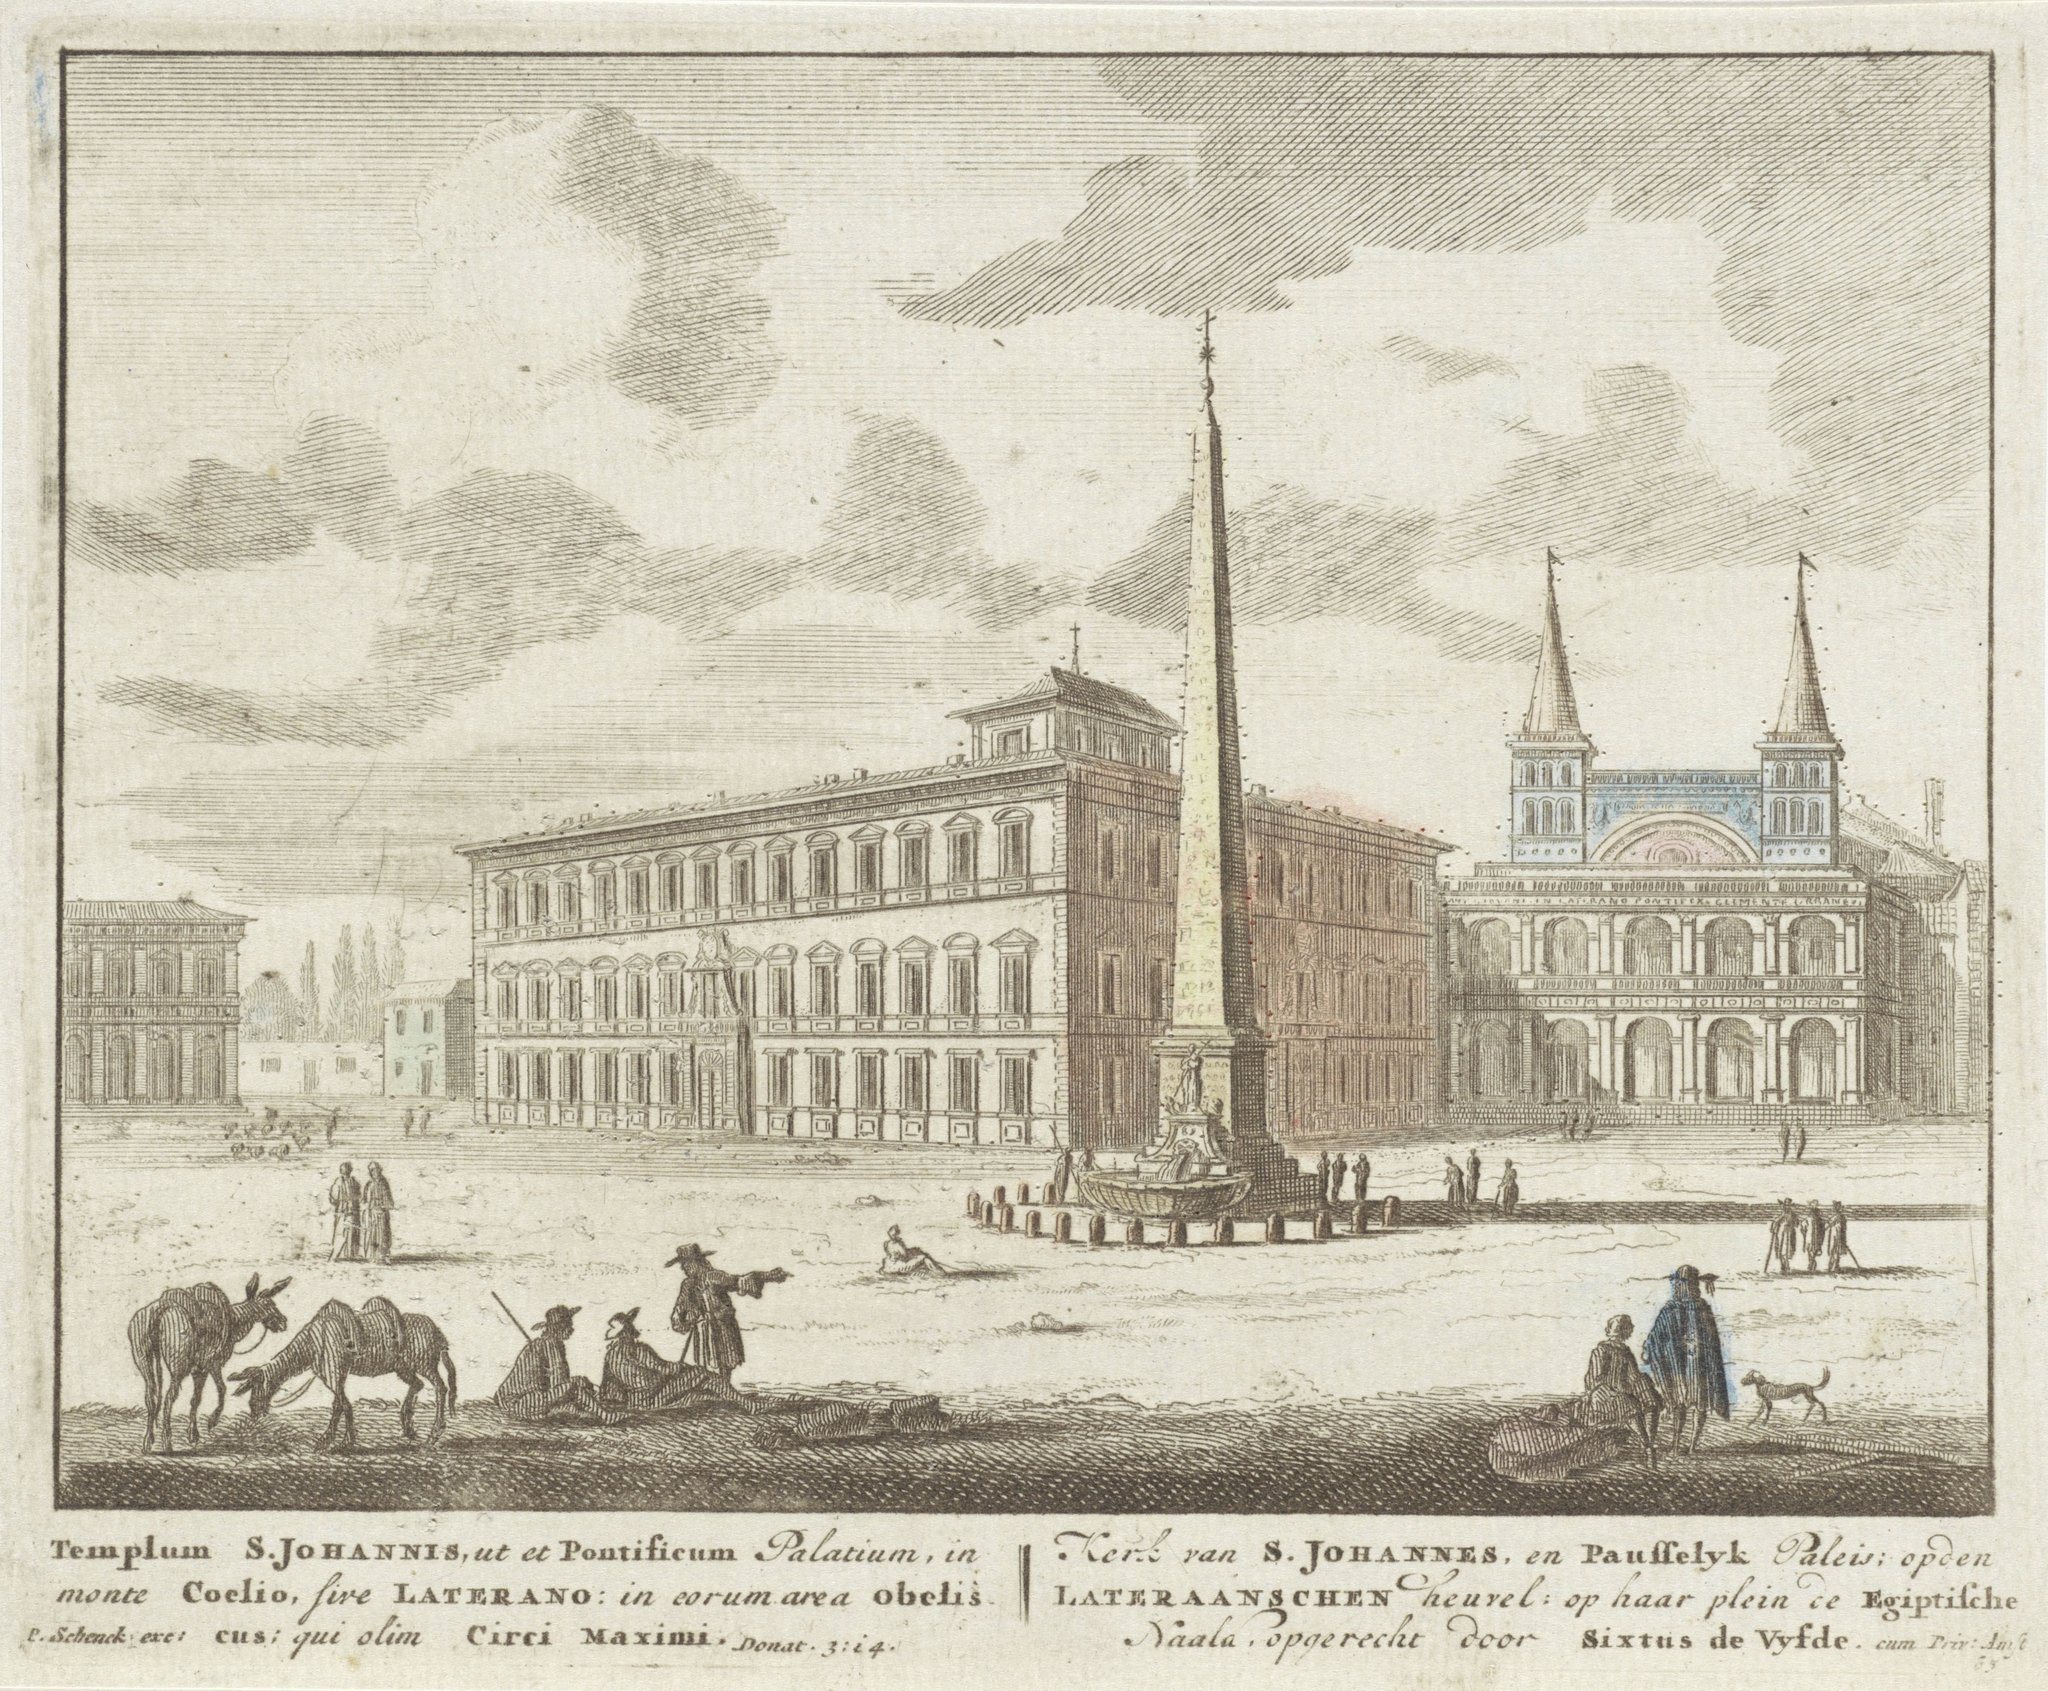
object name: print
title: Lateraanse Obelisk en het Lateraans Paleis te Rome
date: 1675-1711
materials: paper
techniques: etching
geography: amsterdam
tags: obelisk, needle, rome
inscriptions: collector's mark: Lugt 2228